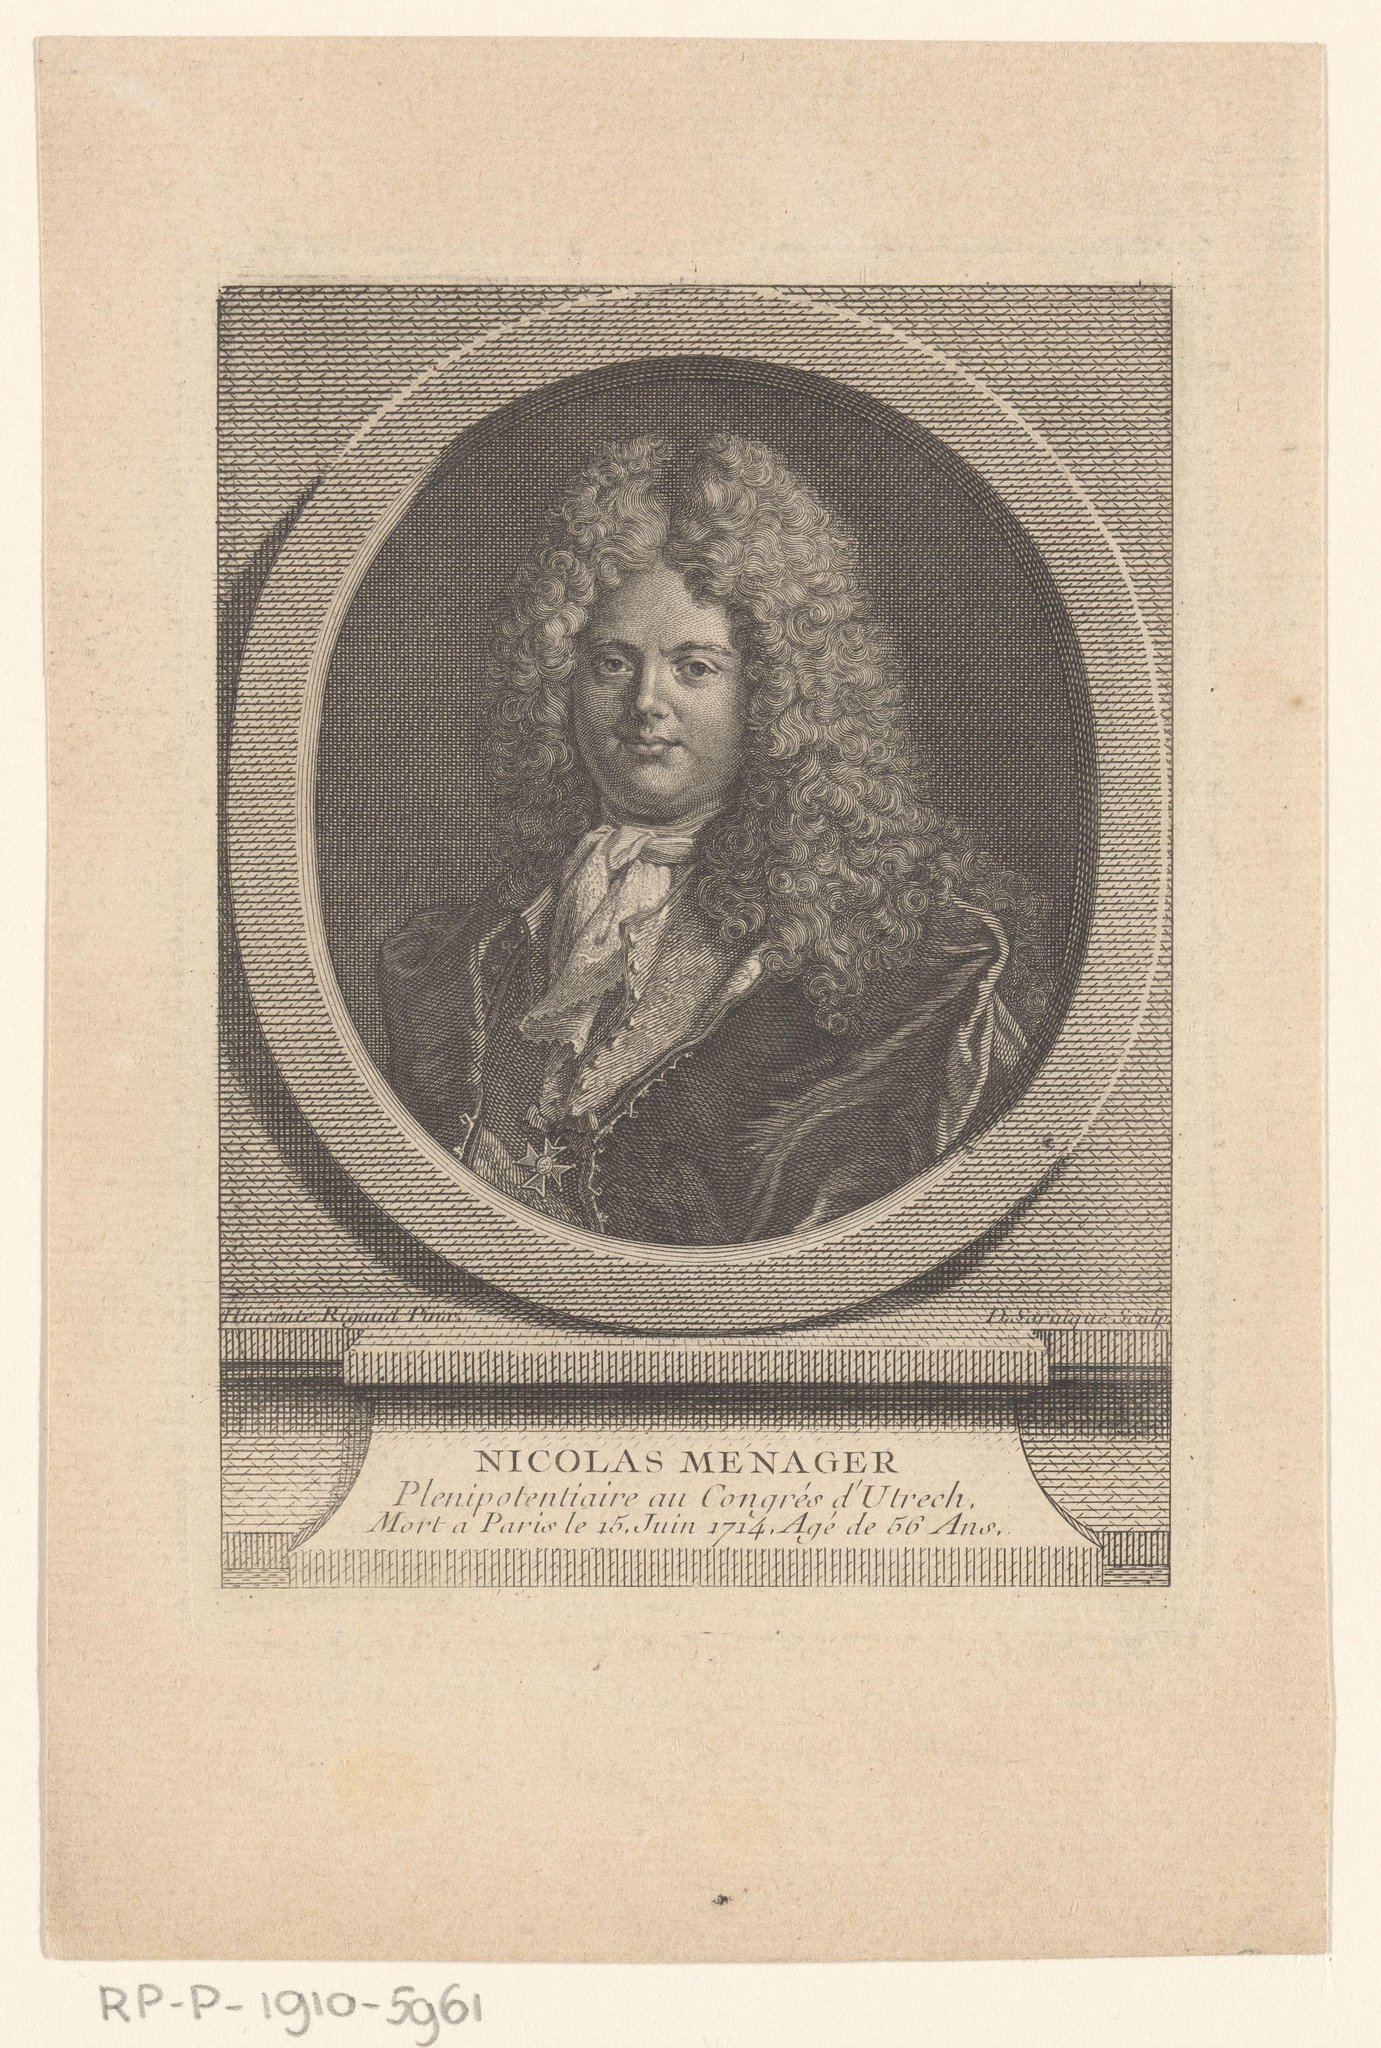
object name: print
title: Portret van Nicolas Mesnager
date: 1755-1765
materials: paper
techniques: engraving, etching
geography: paris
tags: paris, historical persons, diplomacy, diplomat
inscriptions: collector's mark: Lugt 2228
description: Prent uit: Dreux du Radier, Jean-François. L'Europe illustré, contenant l'histoire abregée des souverains, des princes, des prélats, des ministres, (...) en Europe: dans le XVe. siècle compris, jusqu'à présent. Parijs: Michel Odieuvre en André-François Le Breton, 1755-1765.